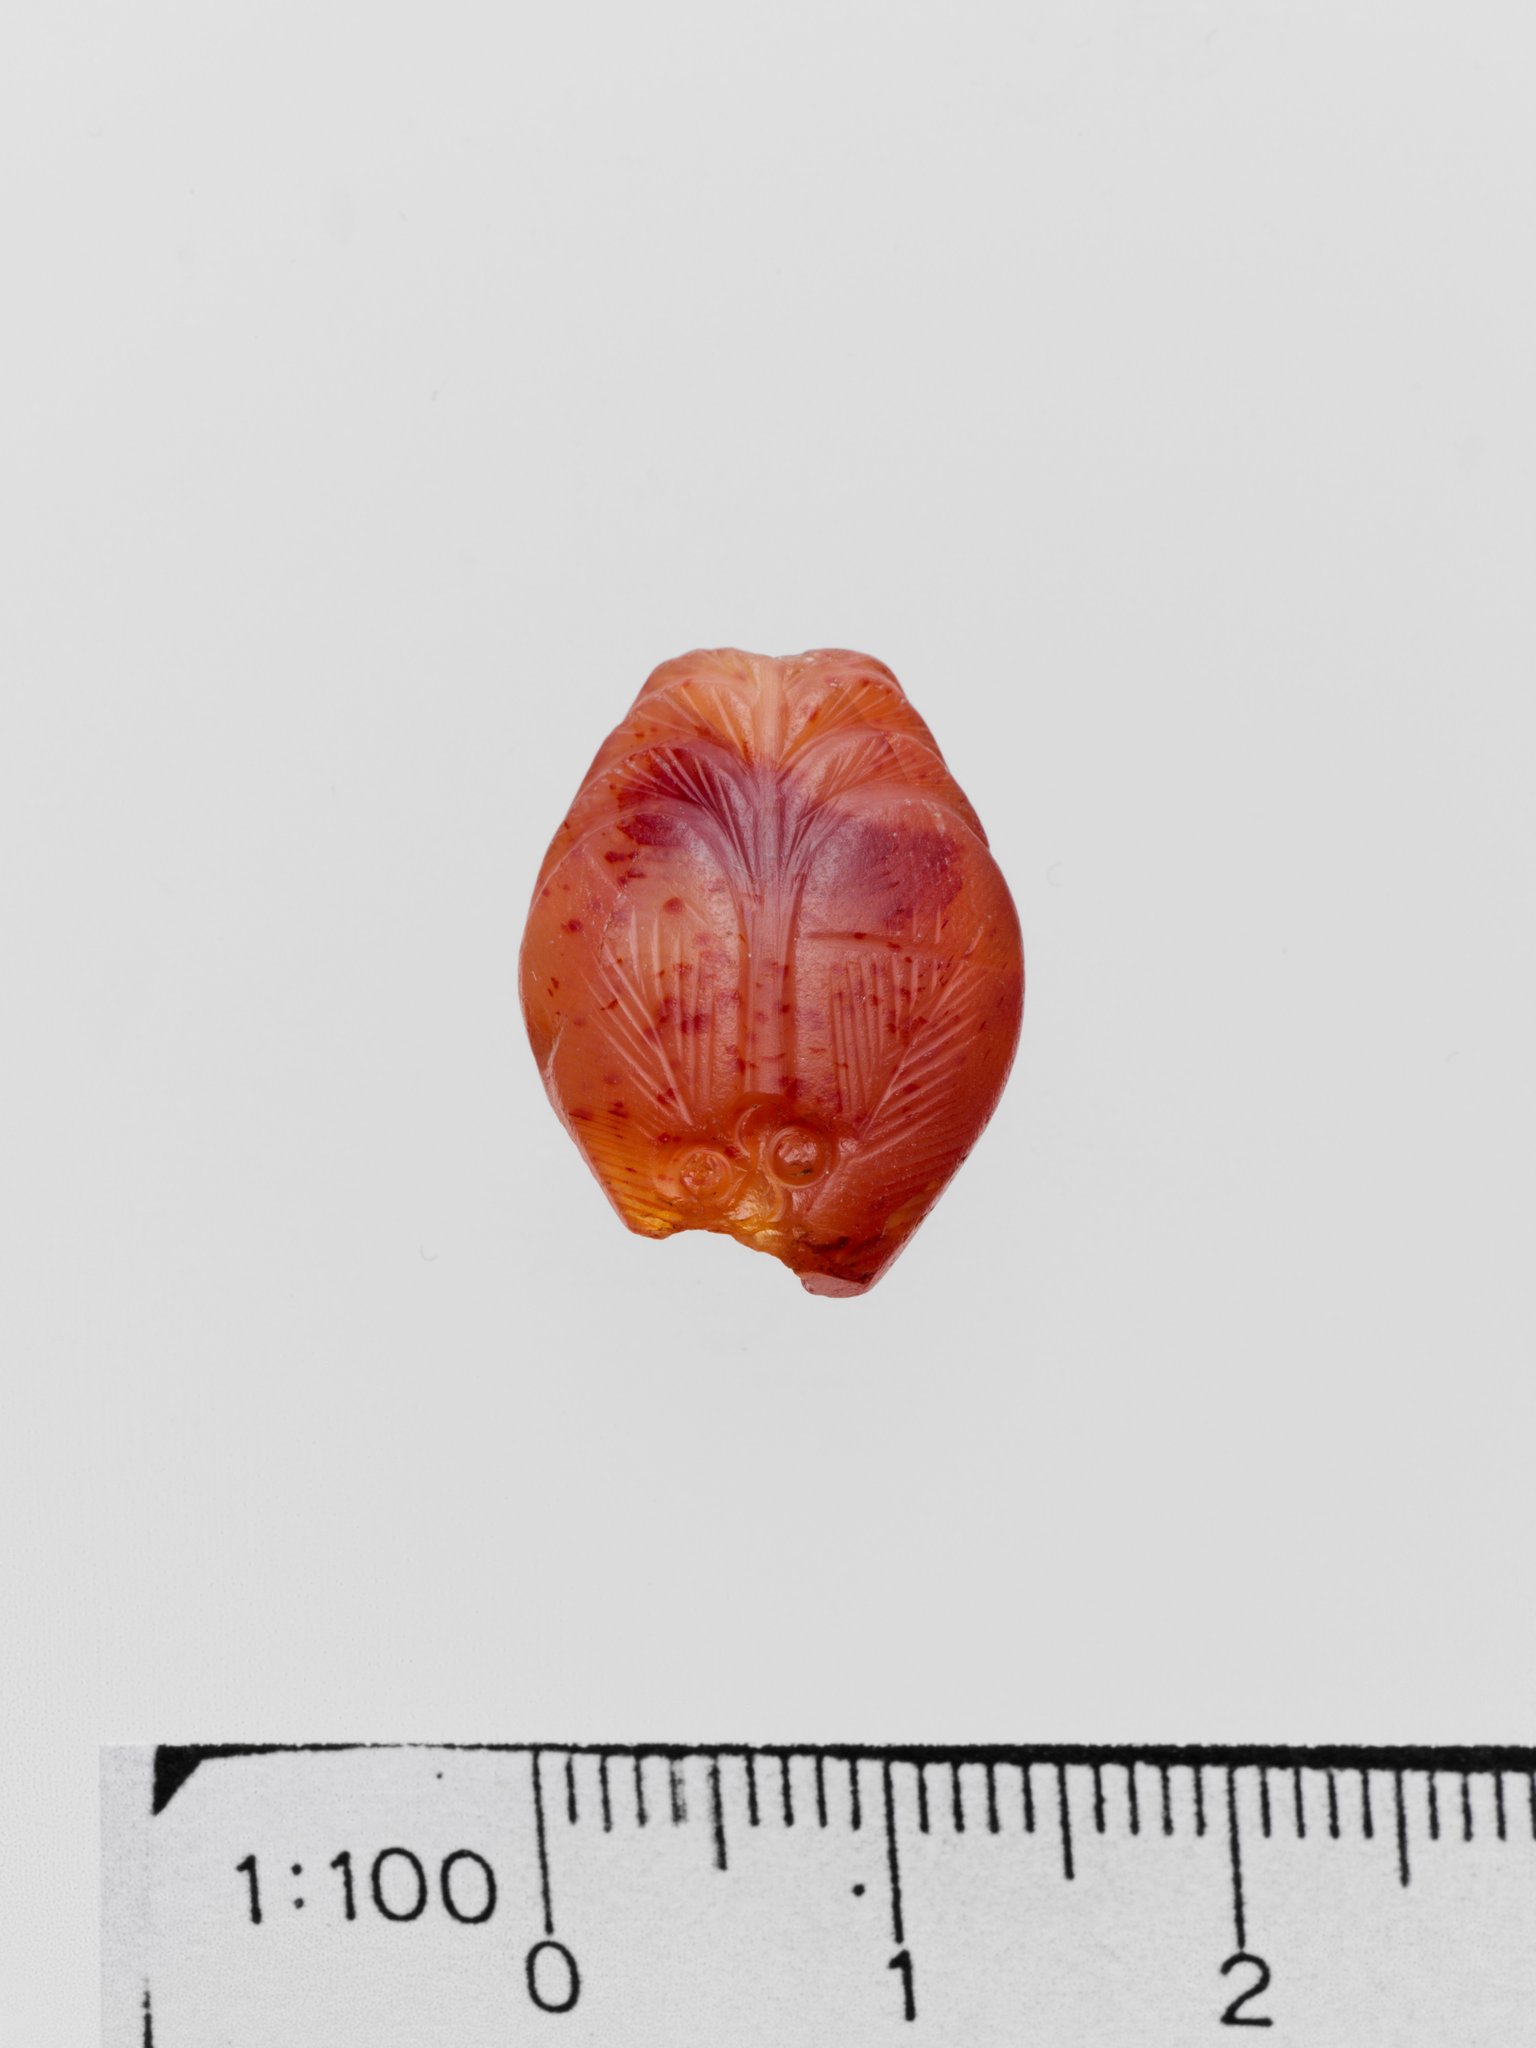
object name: seal, amygdaloid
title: Carnelian amygdaloid seal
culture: minoan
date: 1700-1450 BCE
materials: gemstone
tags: palms